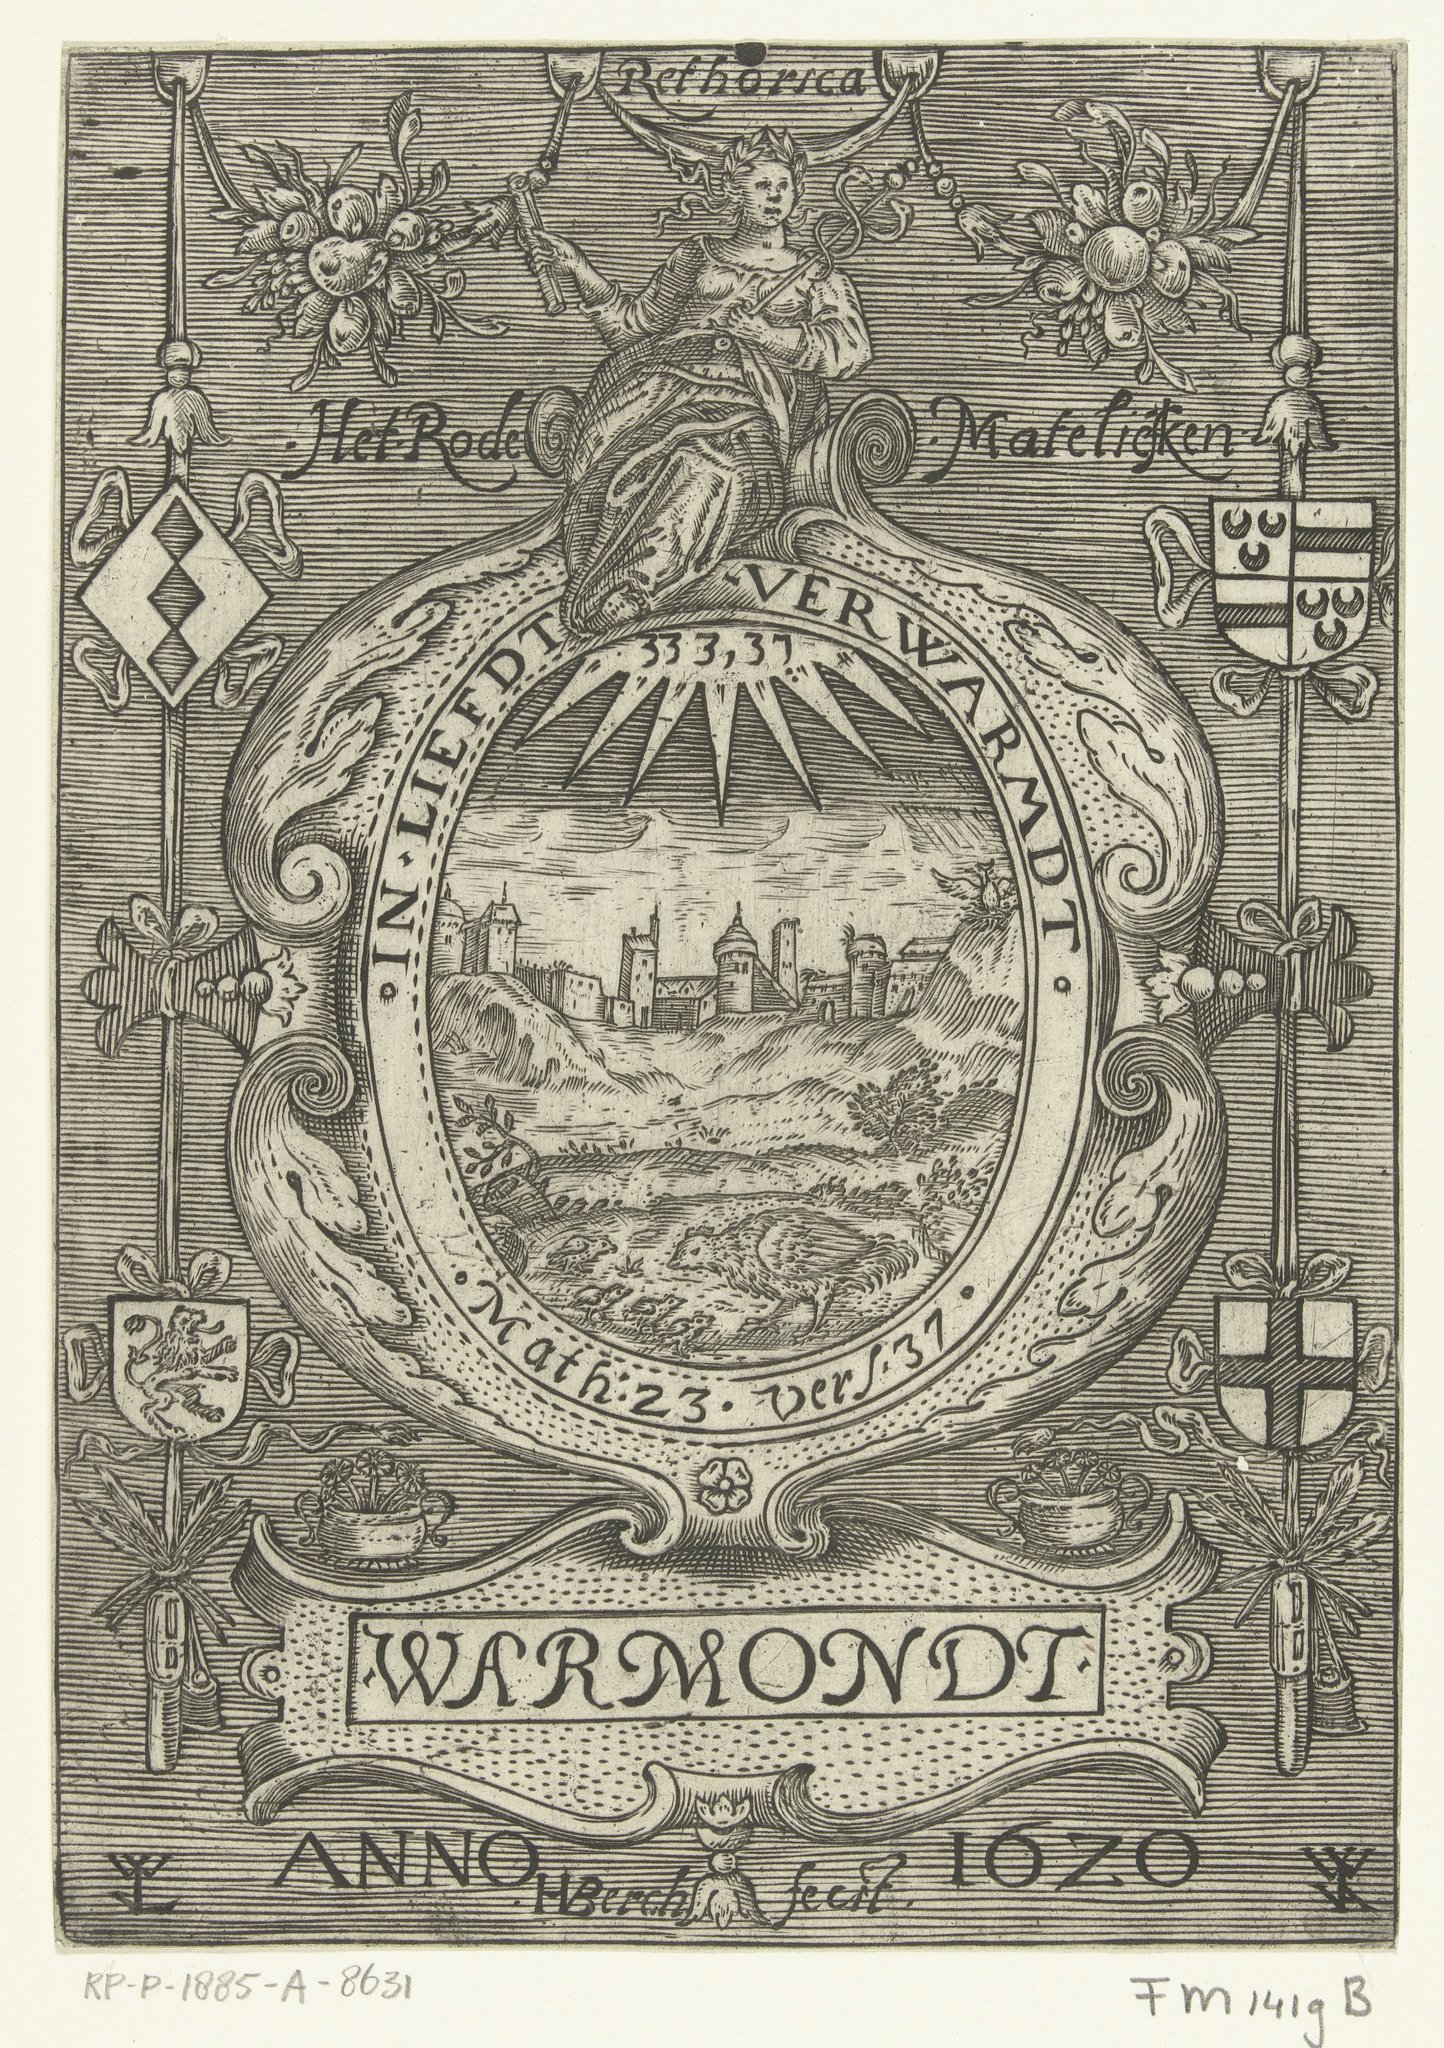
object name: print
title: Het Rode Madeliefken In liefde verwarmdt Warmondt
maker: h. van den berck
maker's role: print maker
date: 1620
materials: paper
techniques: engraving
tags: 'rhetorica', 'eloquentia' (~ trivium); 'rettorica' (ripa), chamber of rhetoric (dutch: 'rederijkerskamer'), warmond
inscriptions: date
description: Blazoen van de rederijkerskamer Het Rode Madeliefje te Warmond, 1620. Blazoen met een hen met haar kuikens in een landschap. Met zittende personificatie van de Rhetorica. Aan weerszijden wapens, strikken en festoenen.